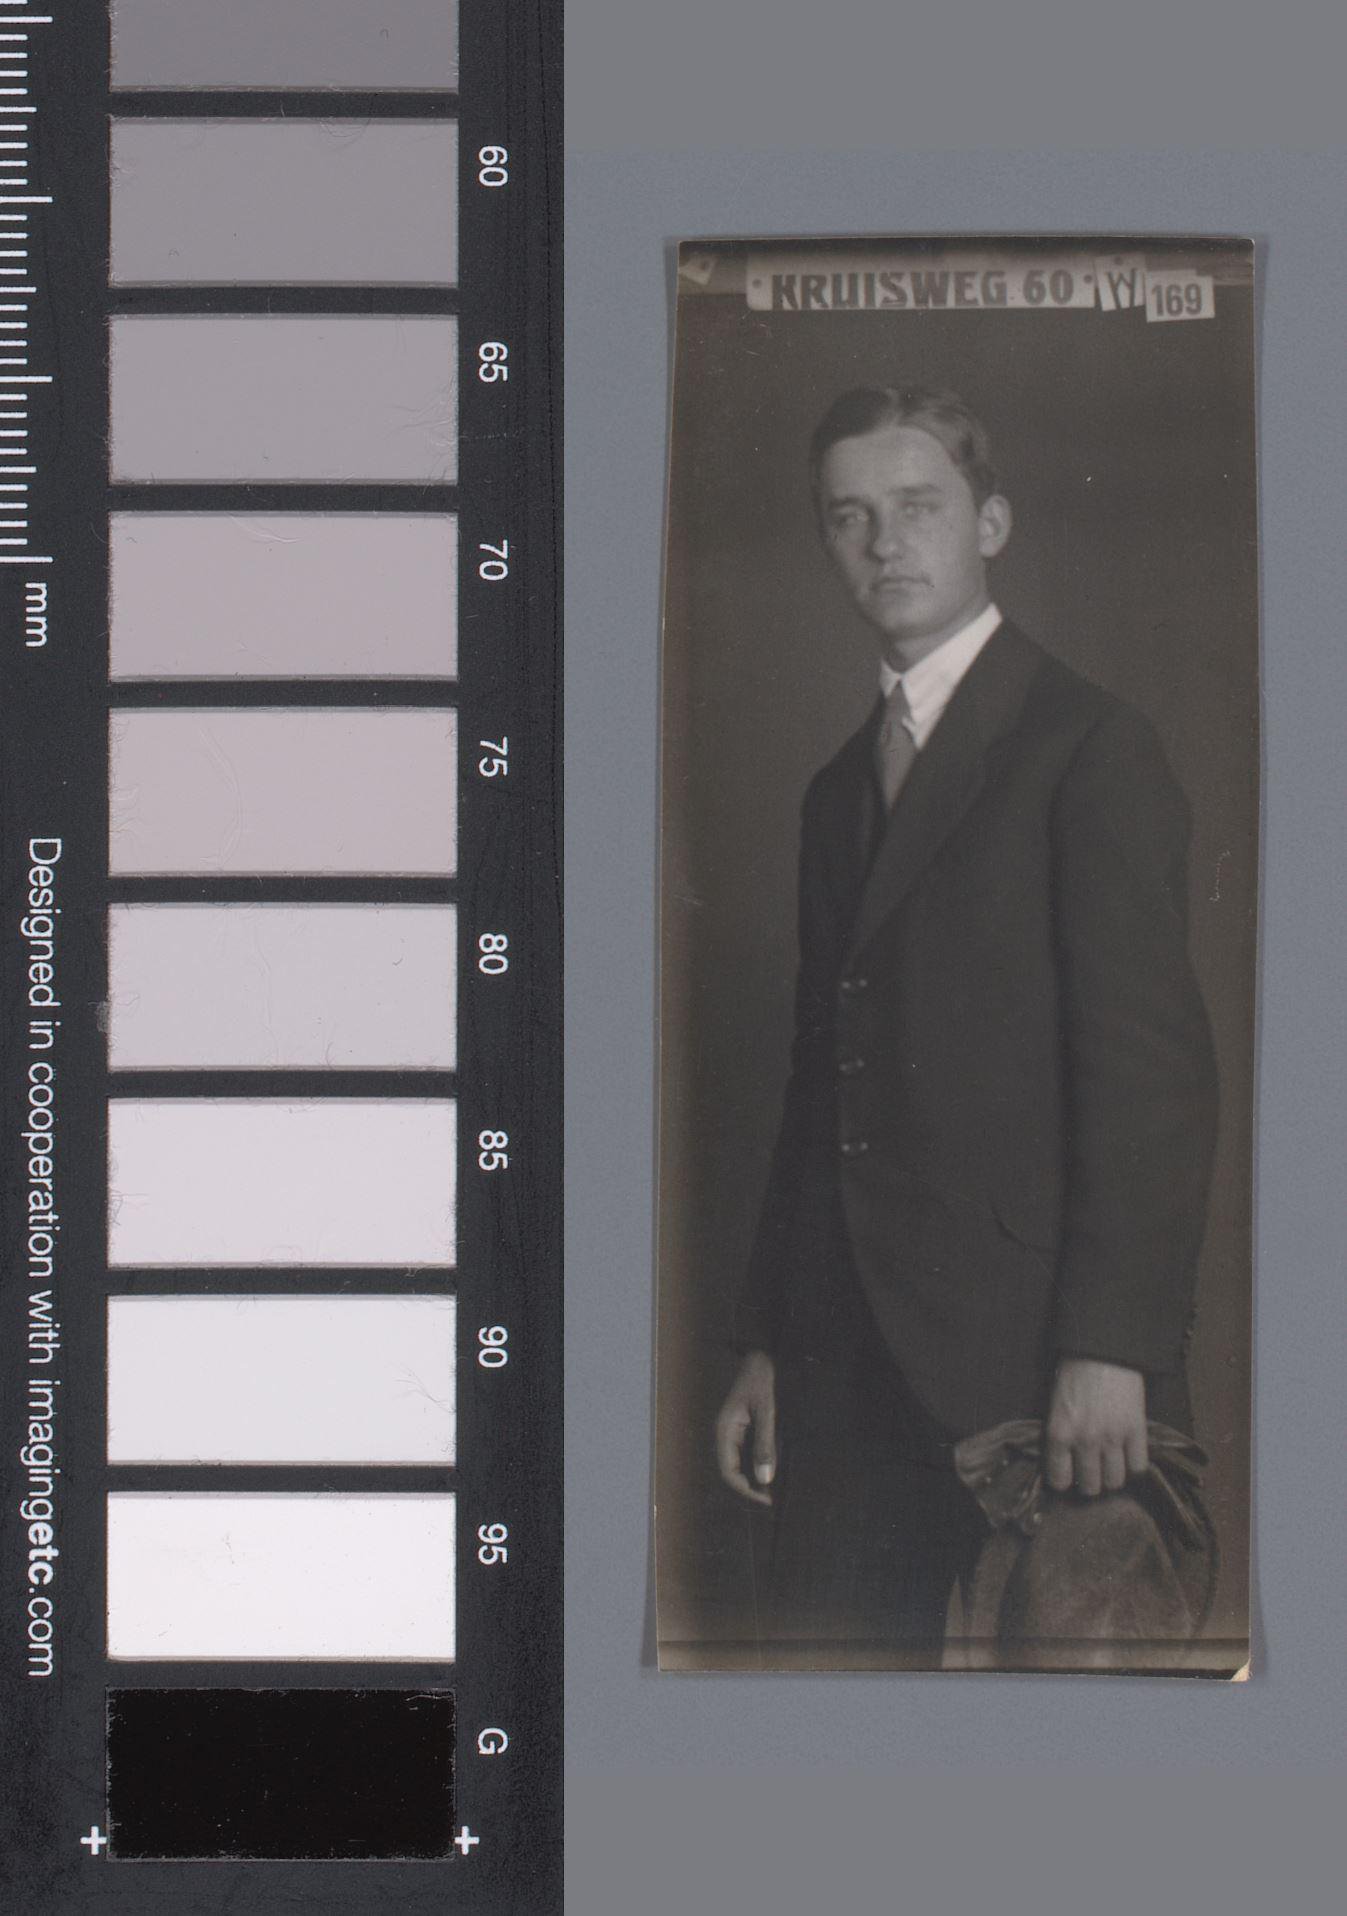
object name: photograph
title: Portret van een onbekende man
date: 1917-1920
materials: photographic support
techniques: gelatin silver print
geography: haarlem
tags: historical persons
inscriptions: inscription: ‘Kruisweg 60, W 169’